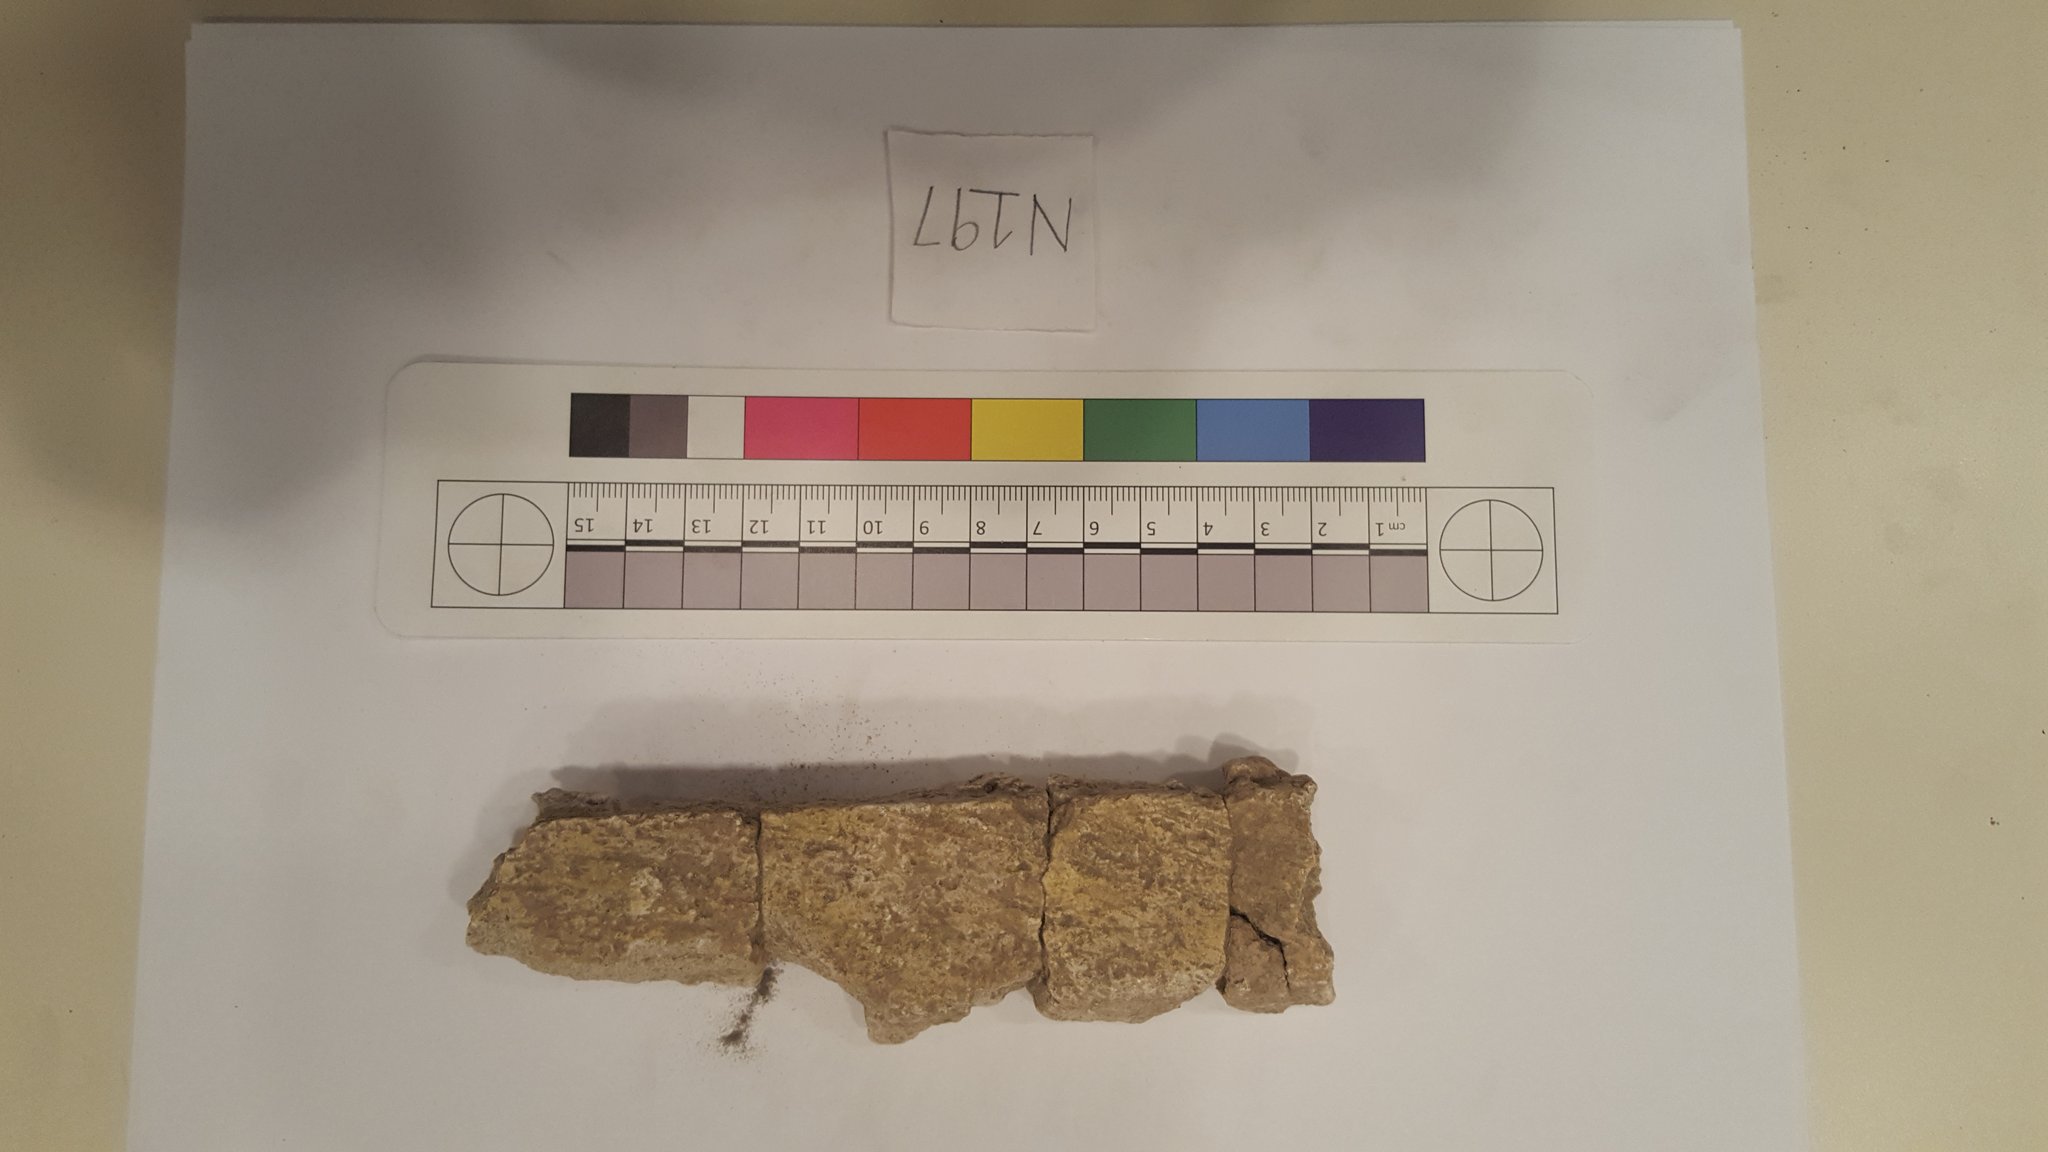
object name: fragment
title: Stucco Fragment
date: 701-1200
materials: plaster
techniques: carving, painting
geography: iran